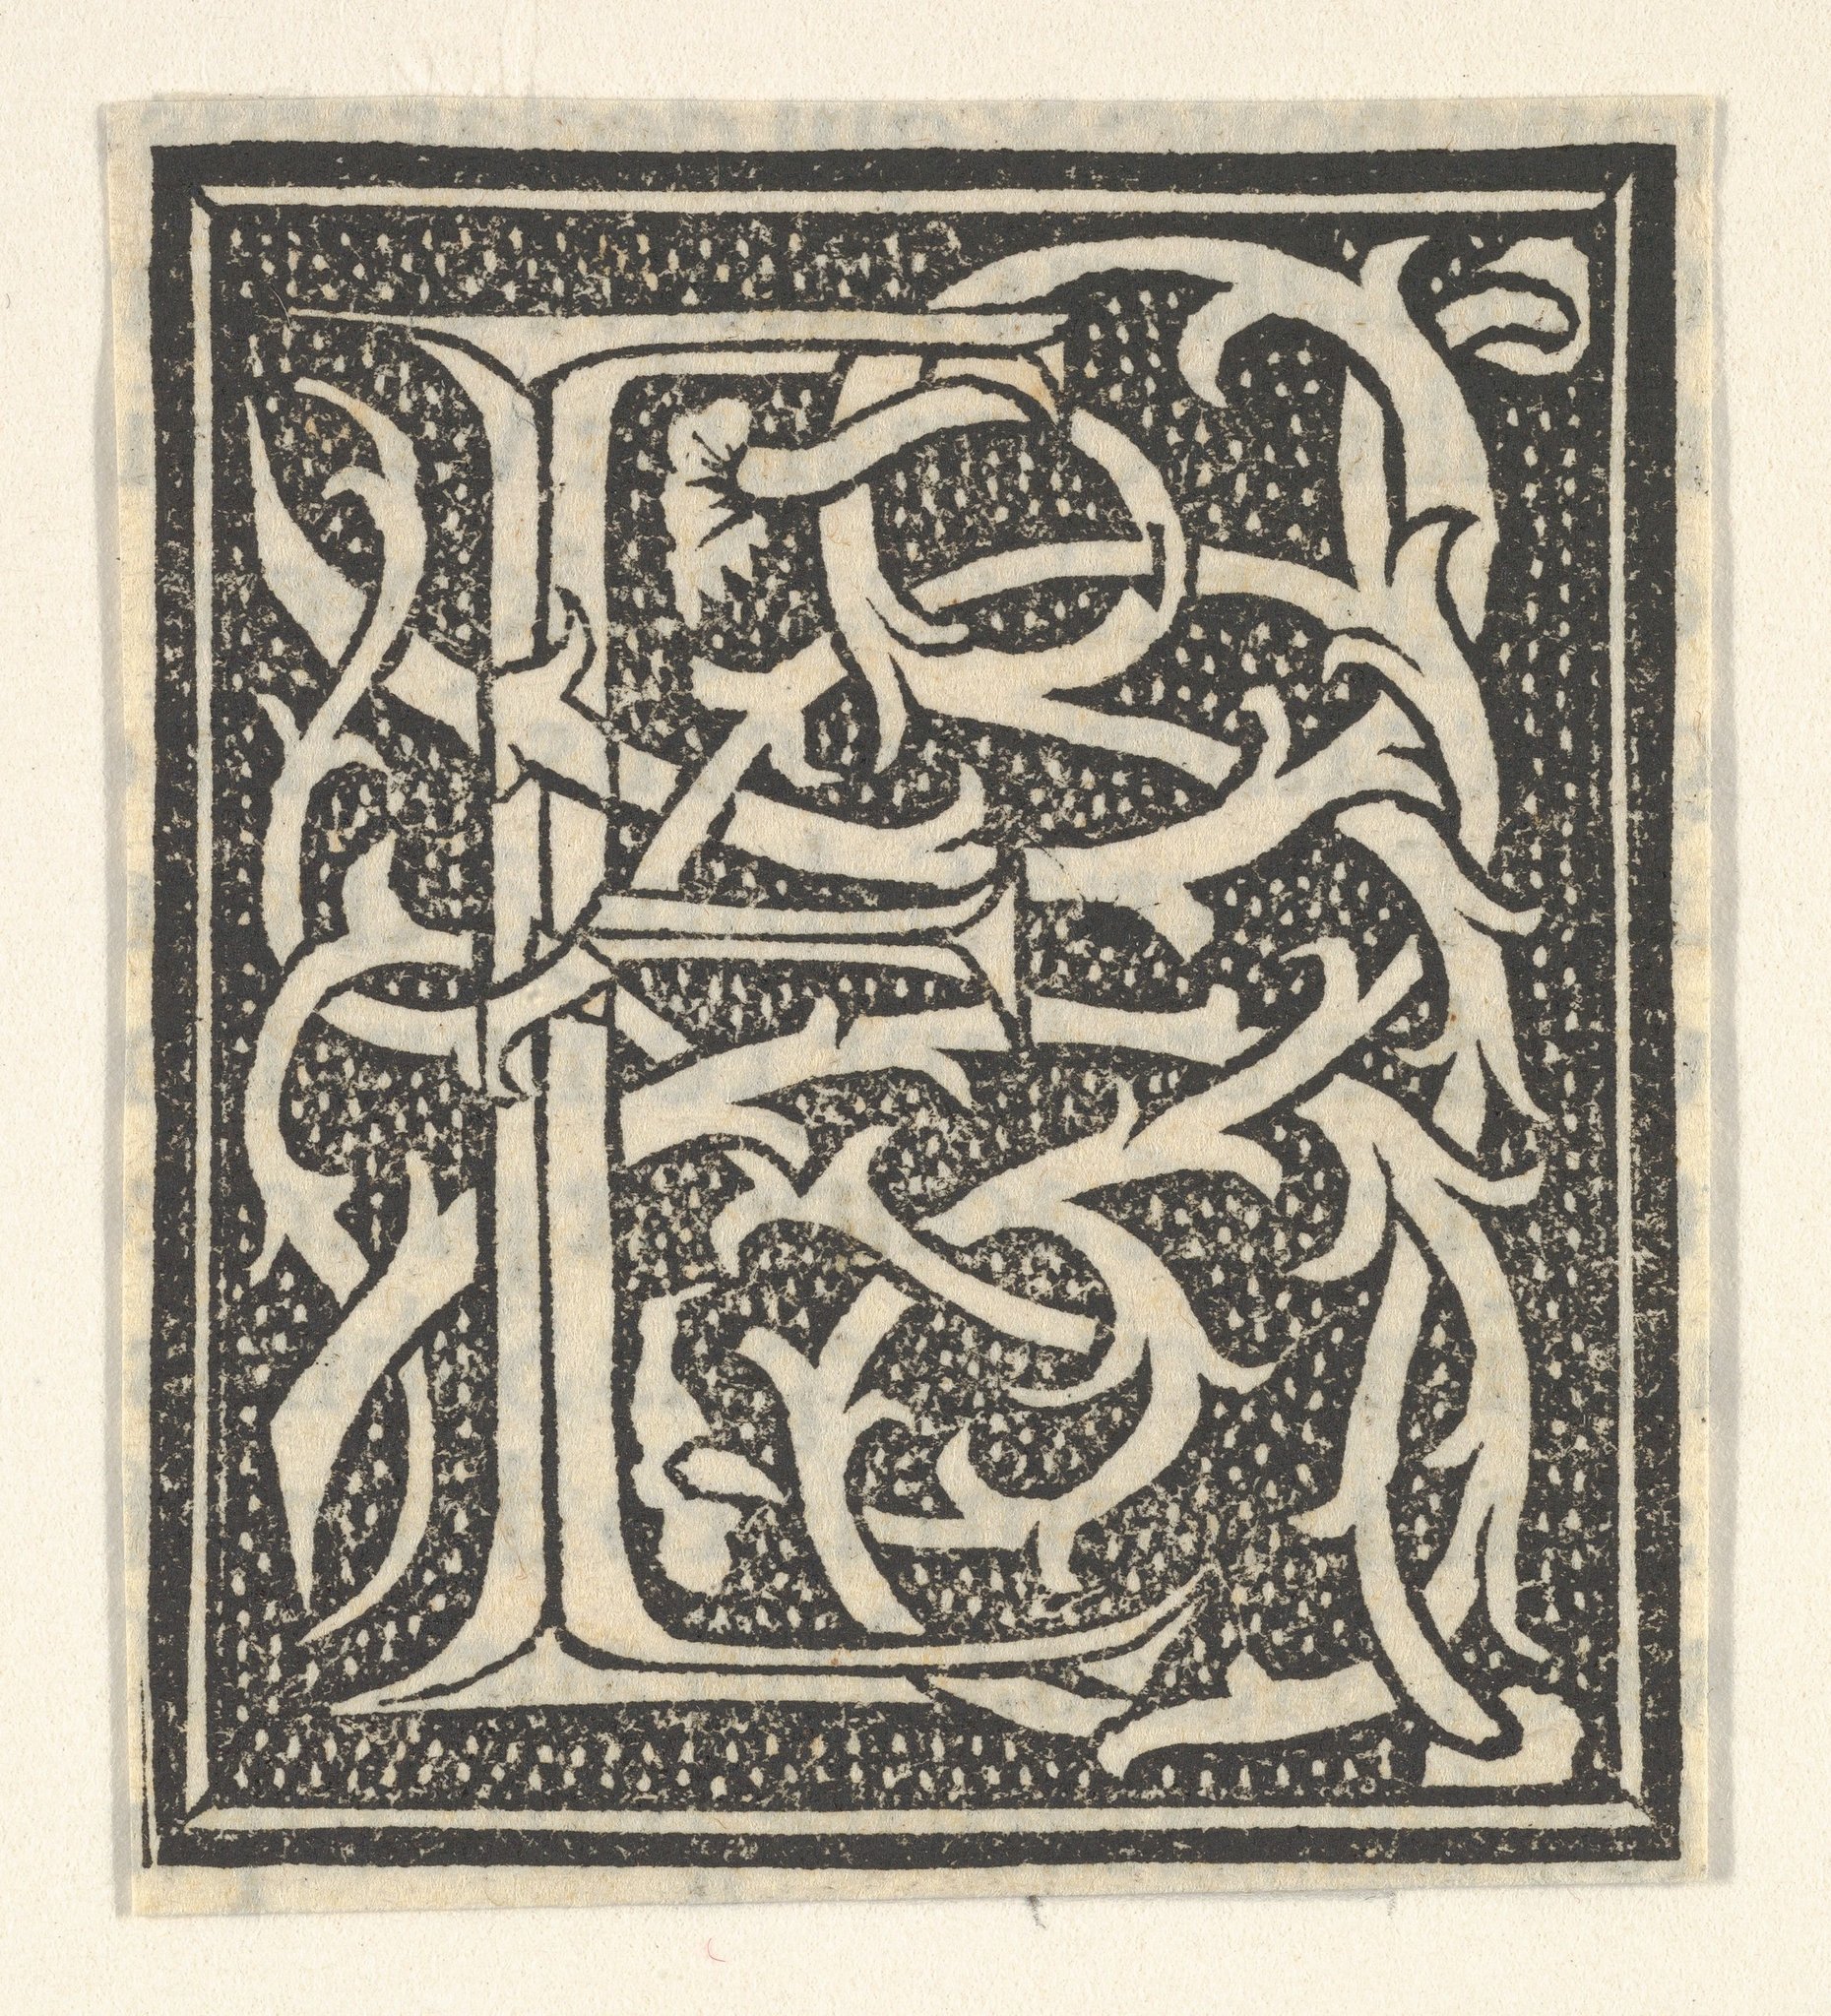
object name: print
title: Initial letter E on patterned background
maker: anonymous, italian, 16th century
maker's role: artist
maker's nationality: italian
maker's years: 1500-1600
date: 1520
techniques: woodcut